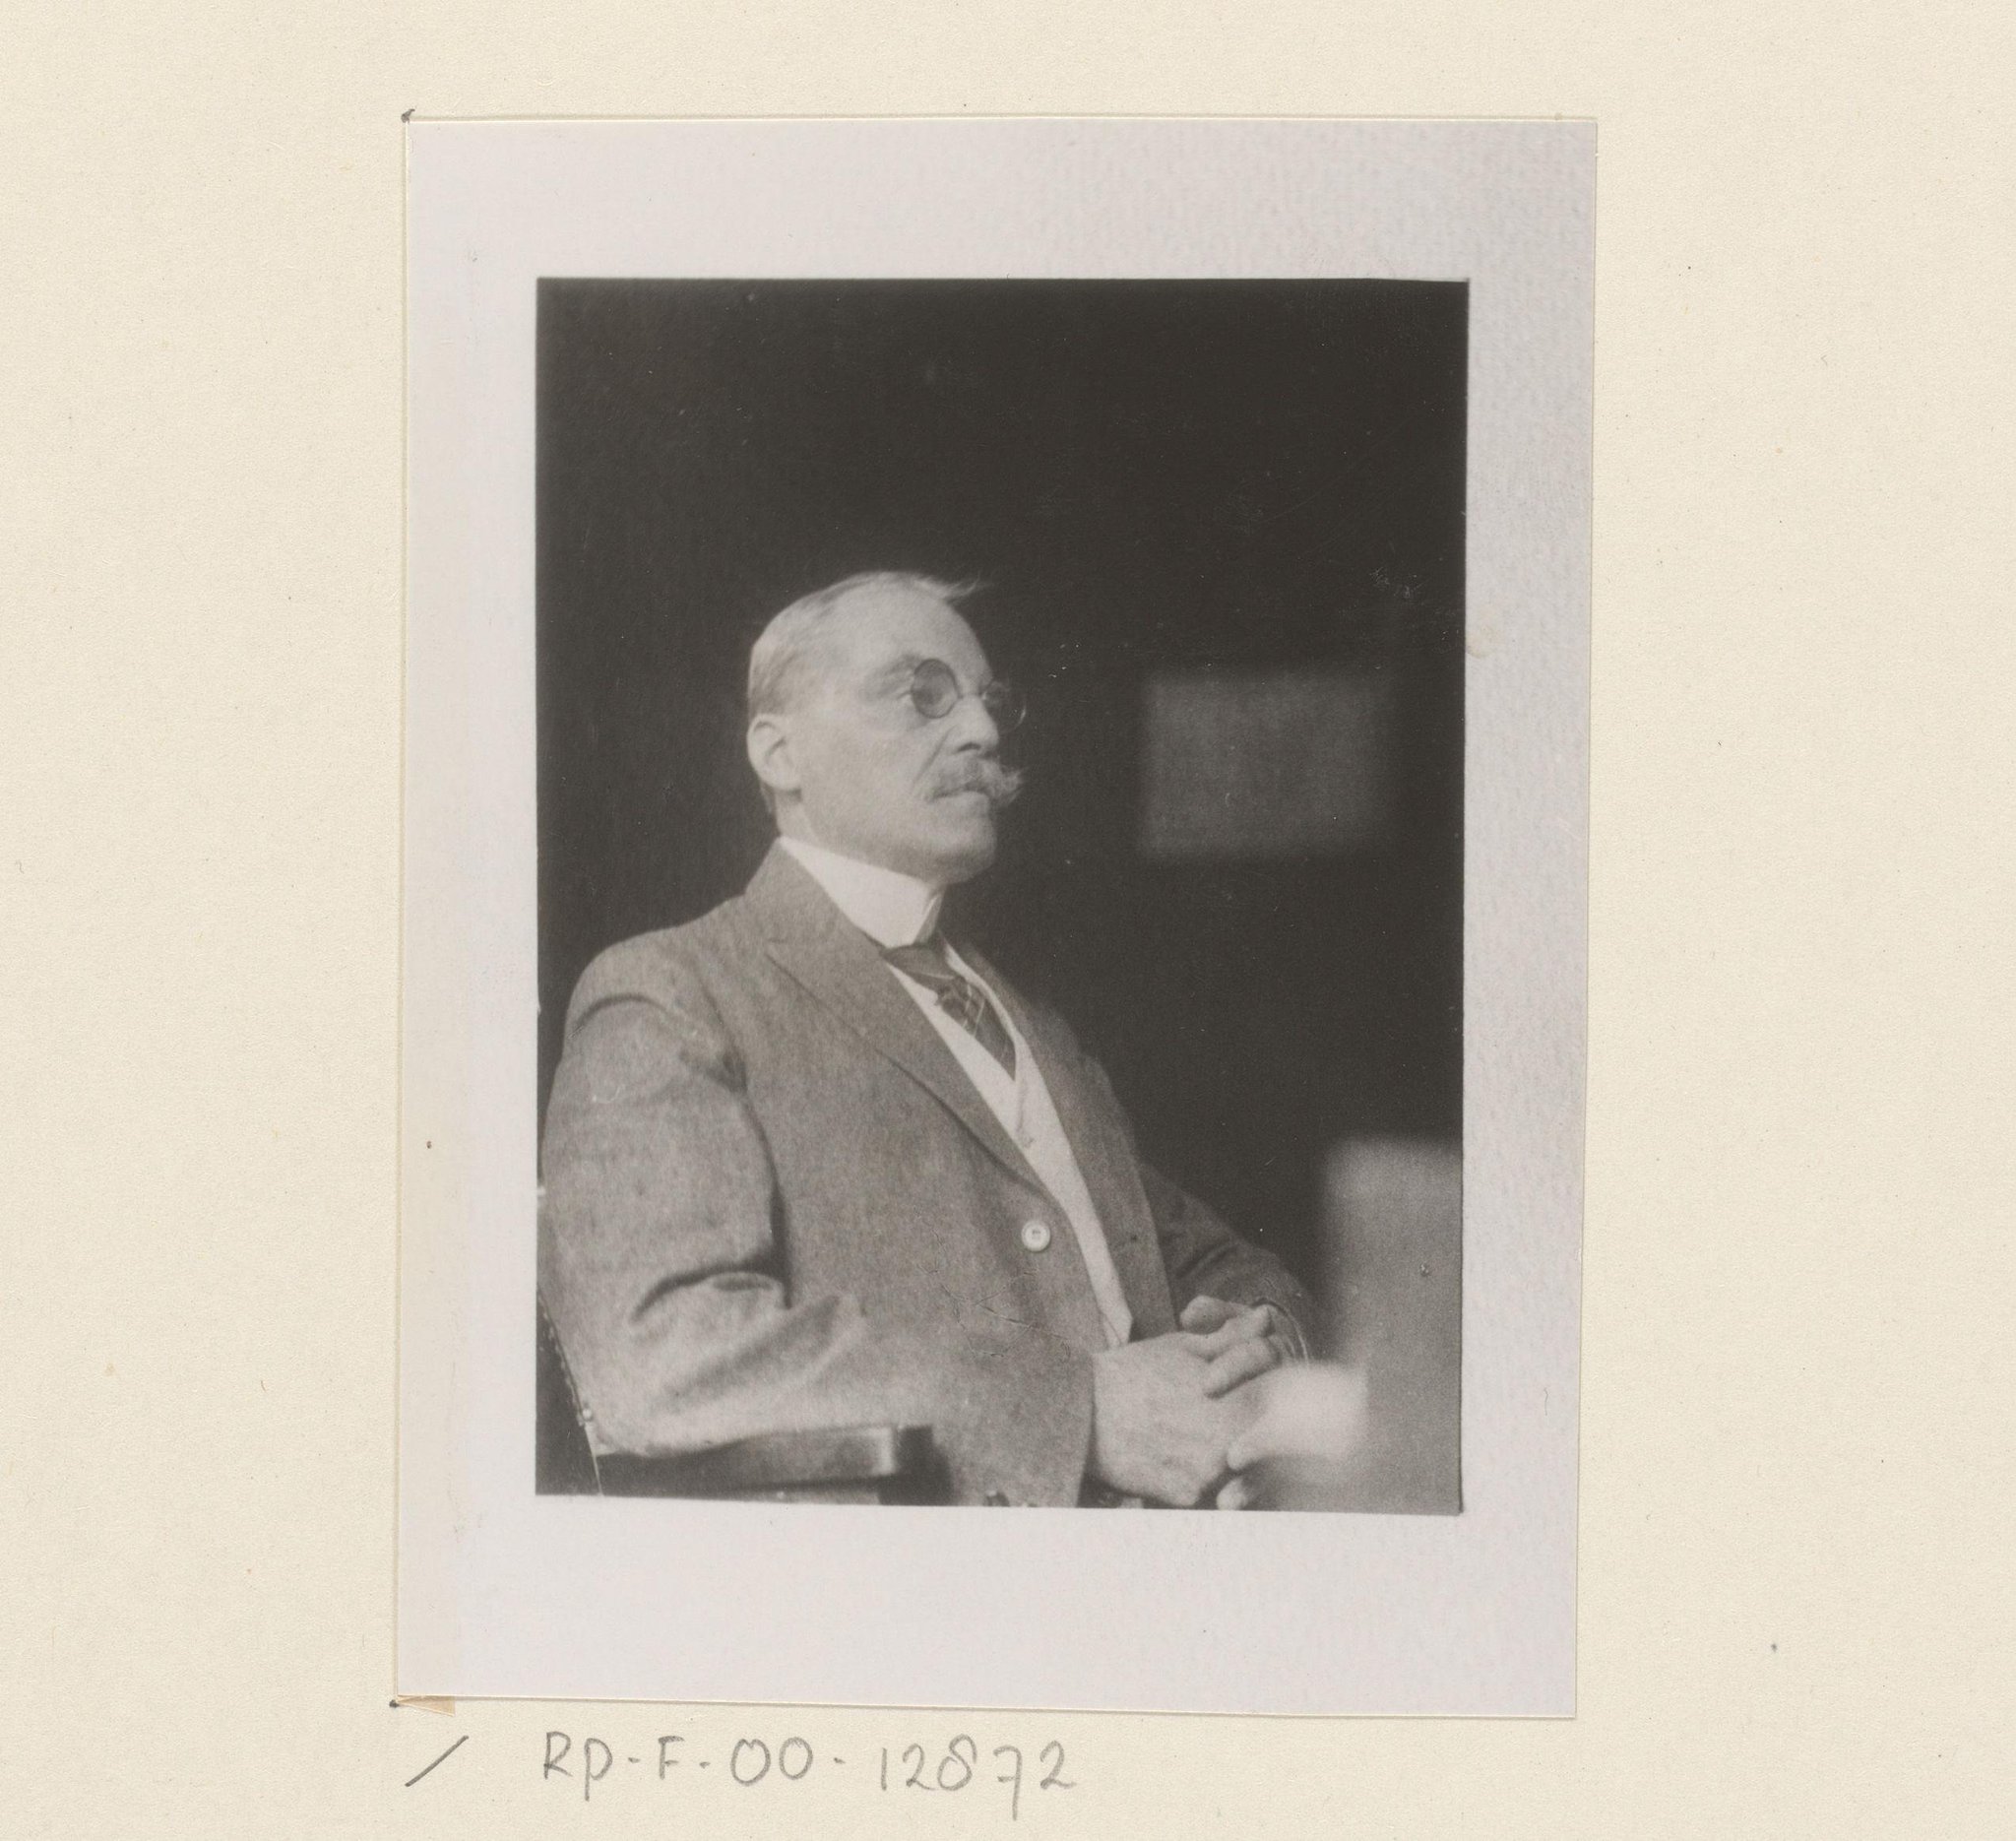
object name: photograph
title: Portret van G. van de Hoeven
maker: Anonymous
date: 1930-1950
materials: paper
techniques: gelatin silver print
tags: journalist, reporter, historical persons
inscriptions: inscription: ‘M G. van der Hoeven/ Hoofdredacteur/ N.R. Courant’